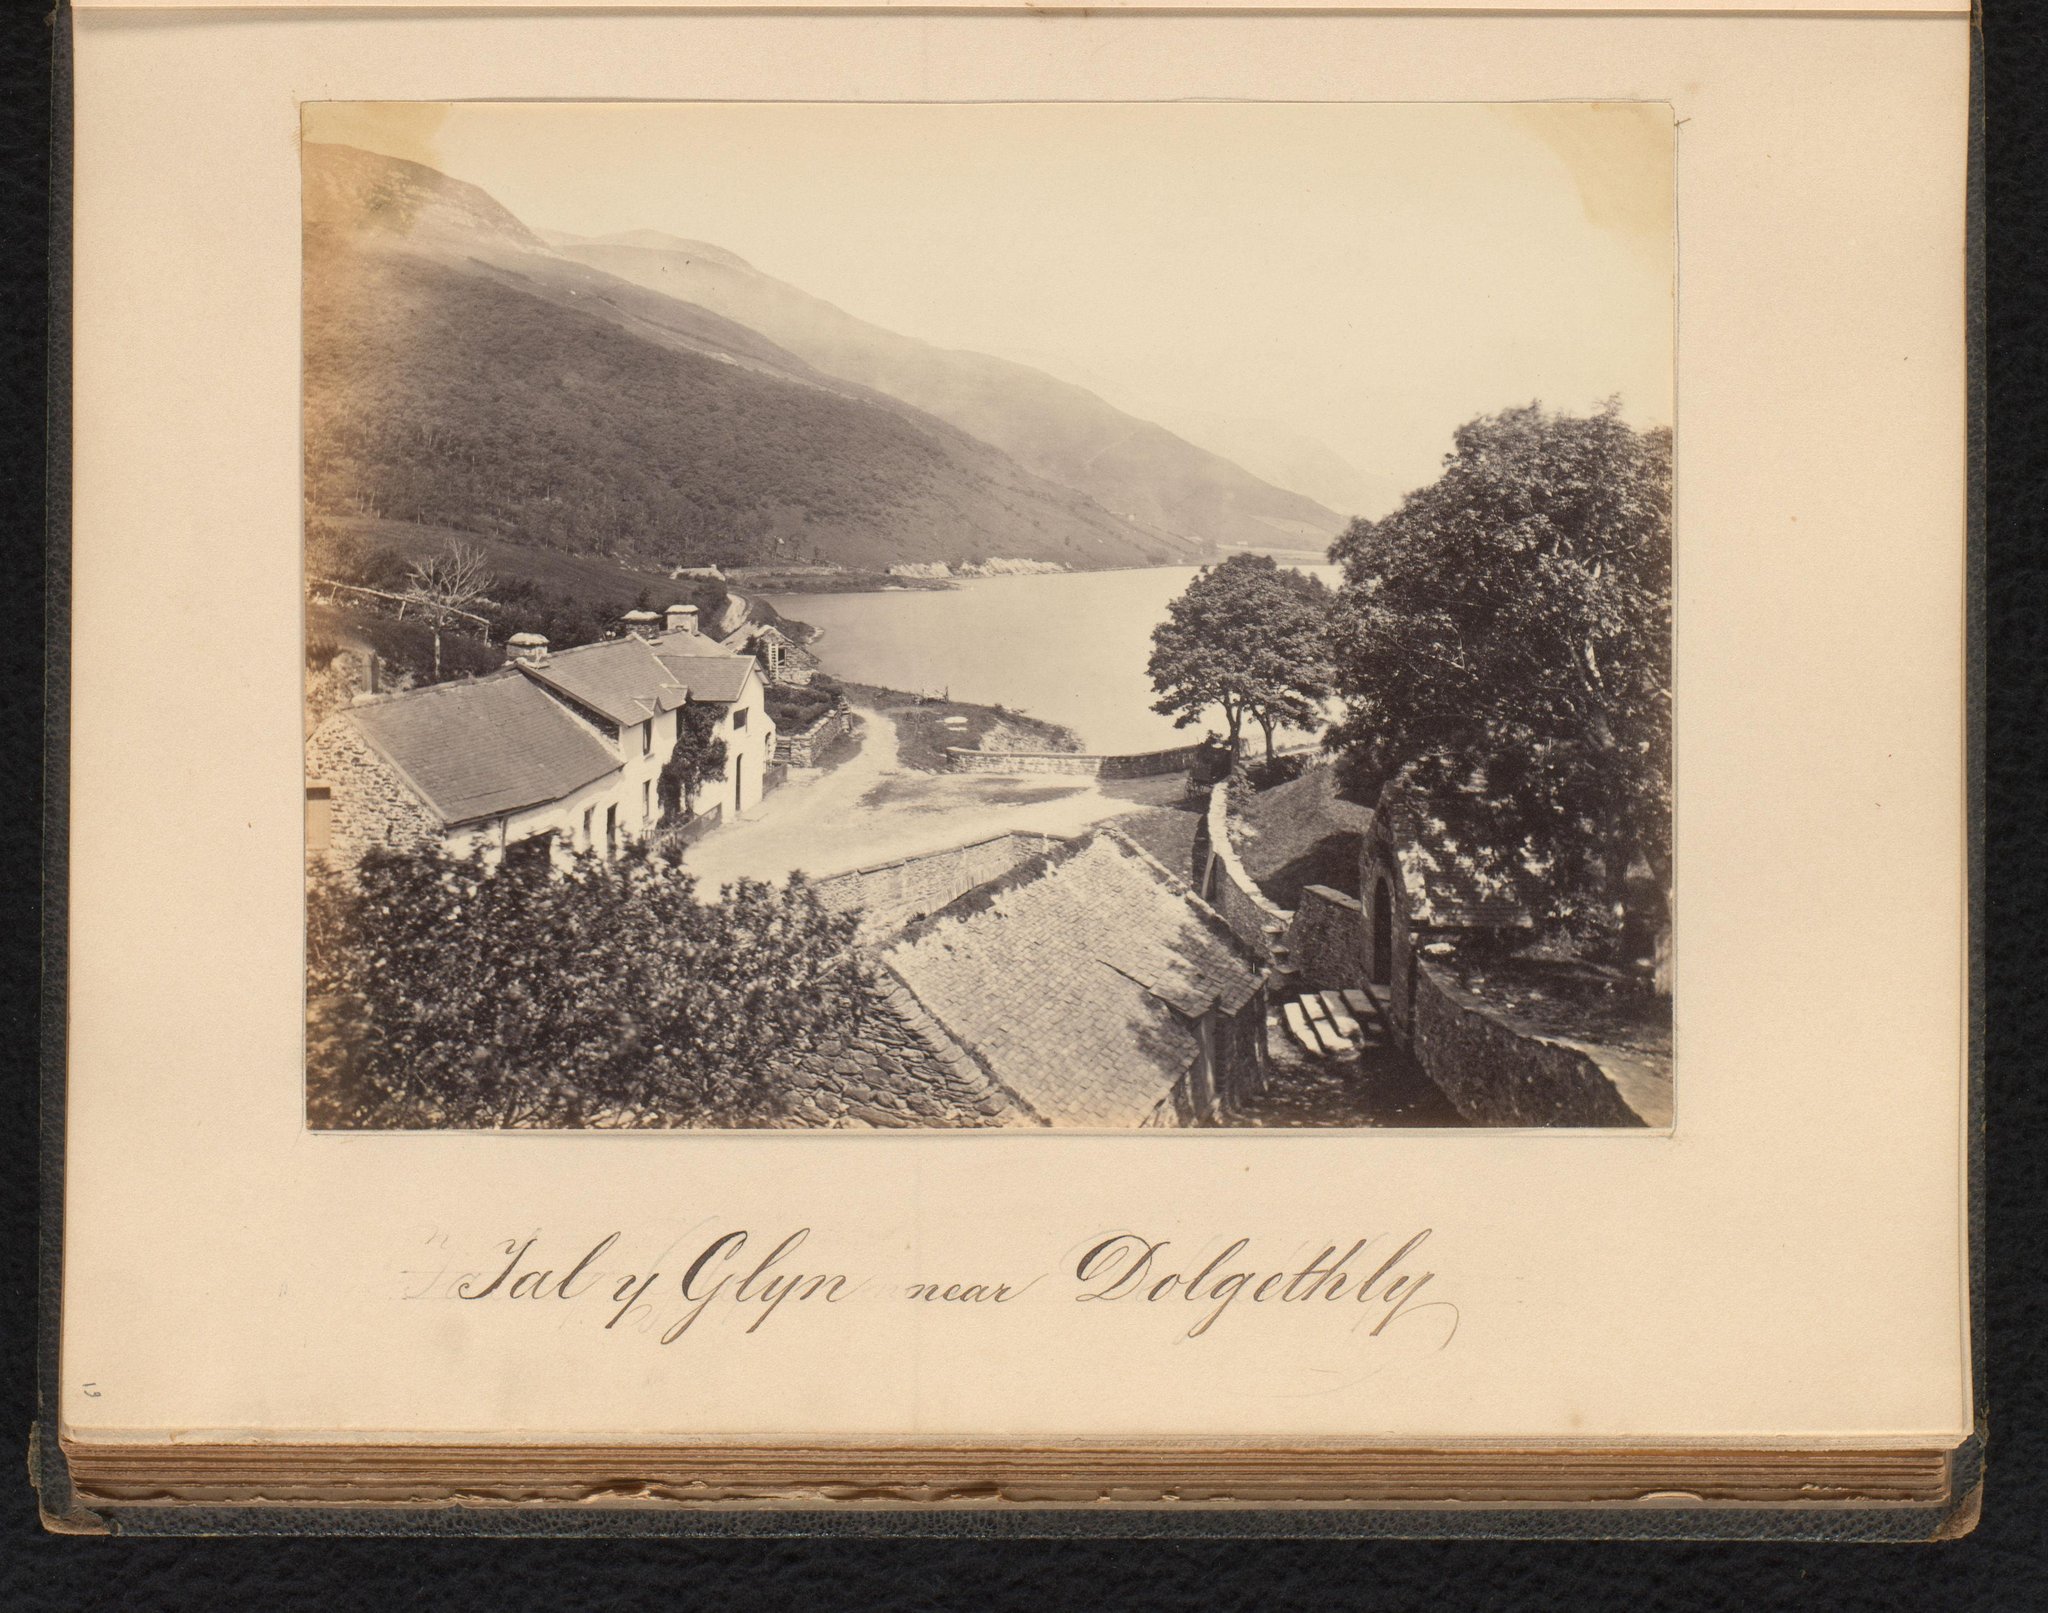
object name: photograph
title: Ial y Glyn near Dolgethly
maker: francis frith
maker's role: publisher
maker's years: 1822-1898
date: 1860-1880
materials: paper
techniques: albumen print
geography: wales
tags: lake